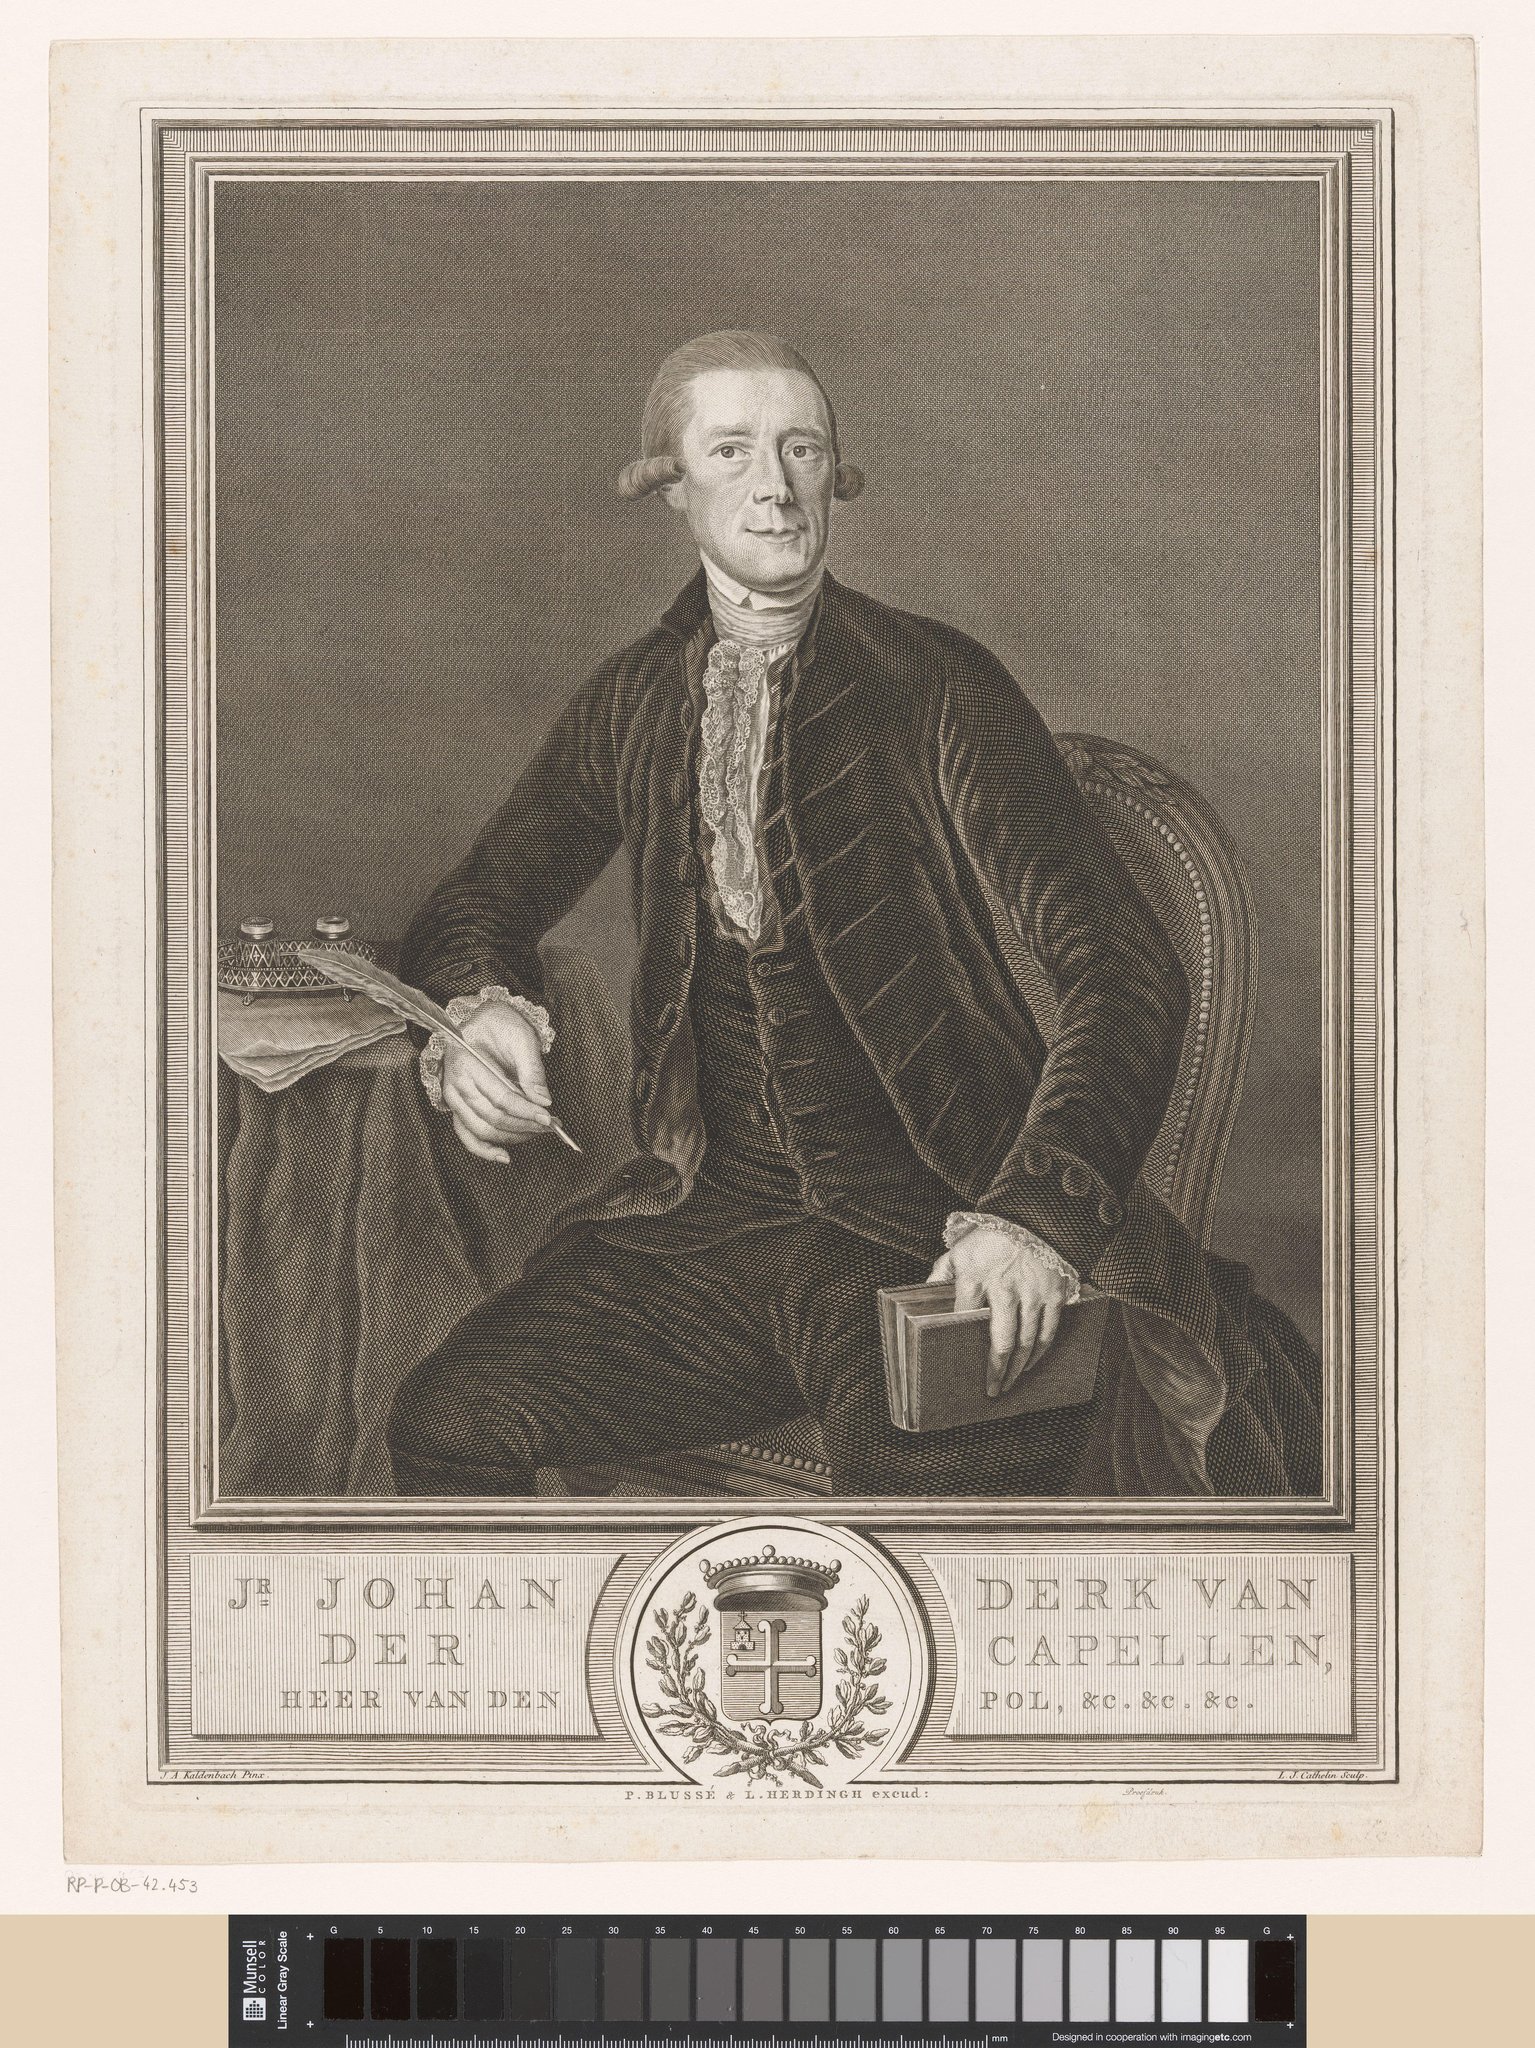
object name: print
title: Portret van Joan Derk van der Capellen tot den Pol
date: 1770-1804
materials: paper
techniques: engraving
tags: politician, joan derk van der capellen tot den pol, quill, historical persons, politician, e.g. party leader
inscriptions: collector's mark: Lugt 2228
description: Bijgevoegd zijn twee opzetvellen met in totaal vijf gedichten op het geschilderde portret van Joan Derk van der Capellen door P. 't Hoen, Jan de Kruyff, D. van Alphen, P. van Schelle en A. Blussé. Joan Derk van der Capellen tot den Pol, heer van Appeltern enz., Nederlands politicus en patriot, schrijver van het anoniem verschenen pamflet 'Aan het Volk van Nederland' (in de nacht van 25 op 26 september 1781 in verschillende steden in Nederland verspreid).